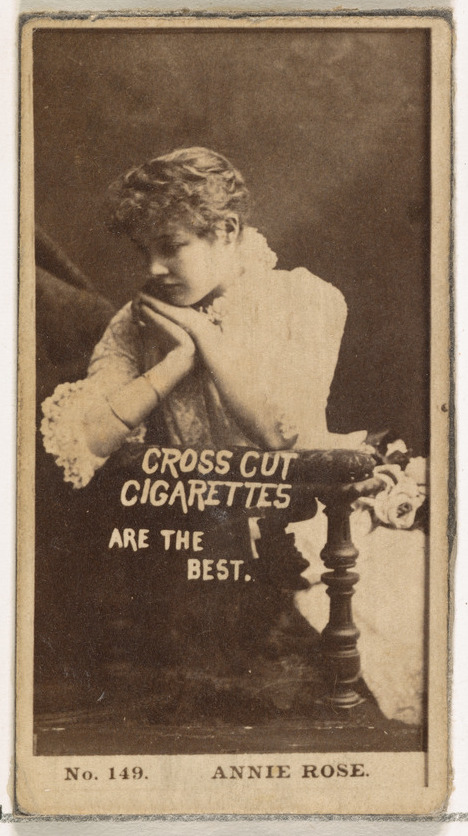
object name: print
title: Card Number 149, Annie Robe, from the Actors and Actresses series (N145-2) issued by Duke Sons & Co. to promote Cross Cut Cigarettes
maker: w. duke, sons & co.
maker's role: publisher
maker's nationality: american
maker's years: 1870-1920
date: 1880-1889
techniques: albumen silver print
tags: portraits,women,actresses